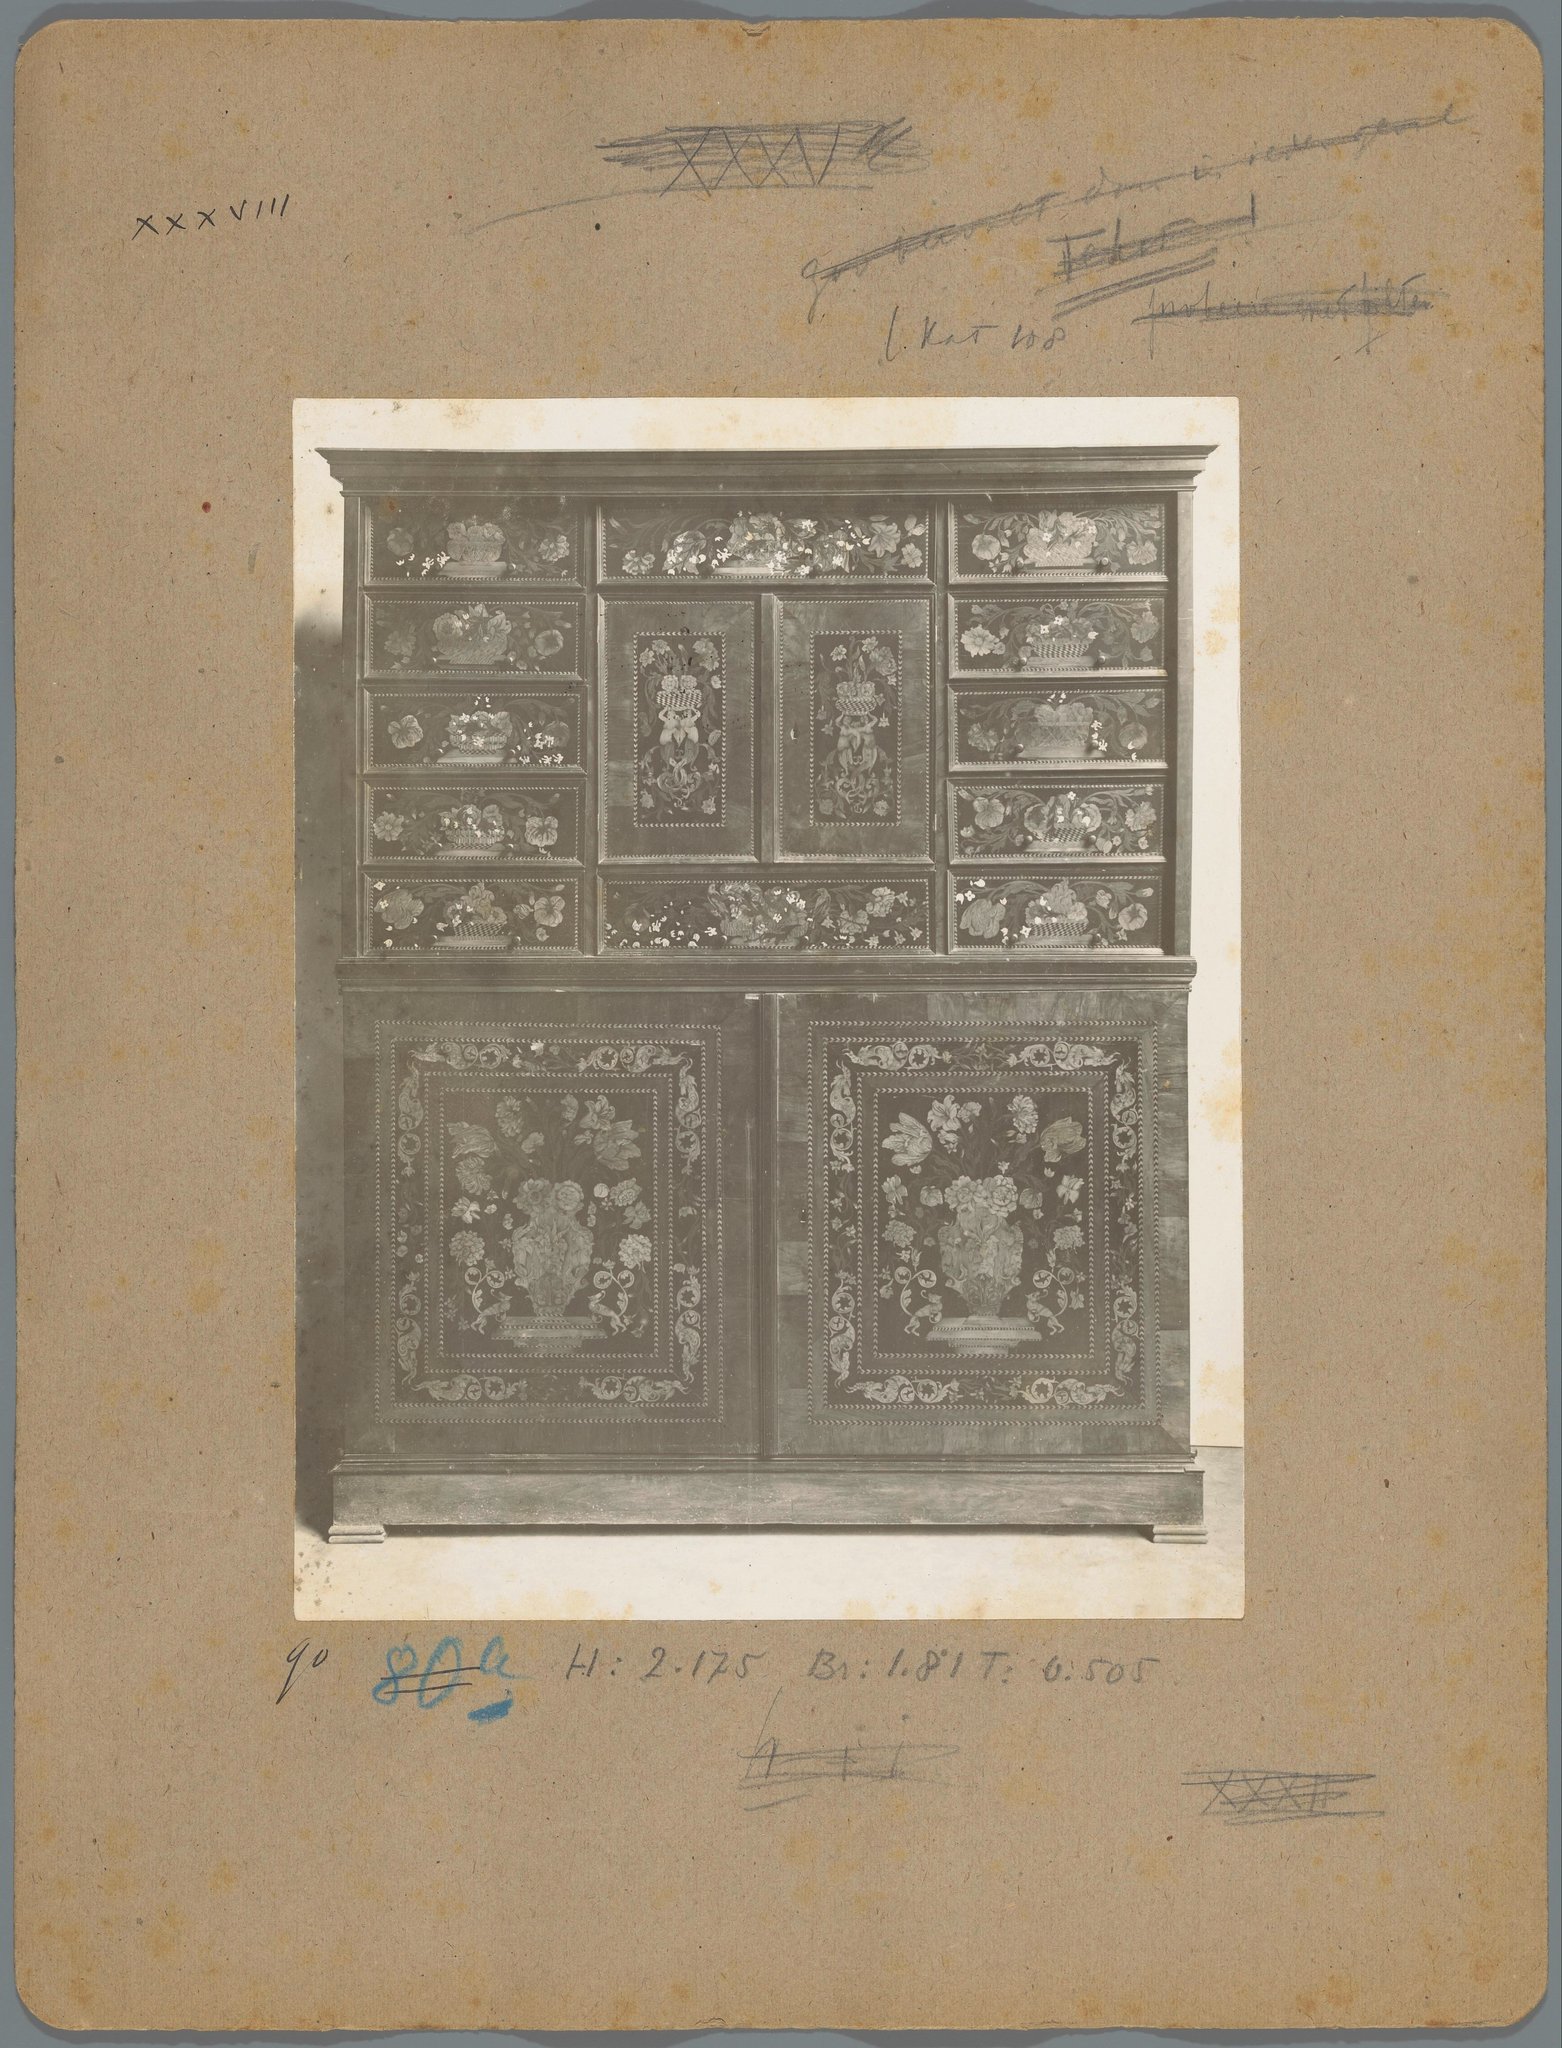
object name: photograph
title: Kabinet met bloemdecoraties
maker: Anonymous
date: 1875-1900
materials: cardboard, photographic support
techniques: gelatin silver print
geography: europe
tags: cupboard, flowers ~ ornament, europe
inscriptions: number: ‘(Kat 108’, collector's mark: ‘KUNSTNIJVERHEIDSCHOOL QUELLINUS AMSTERDAM FRANS HALSSTRAAT 14.’, number: ‘90’, number: ‘XXXVIII’, collector's mark: ‘INSTITUUT VOOR KUNST-NIJVERHEIDSONDERWIJS GABRIËL METSUSTRAAT No. 16 AMSTERDAM’